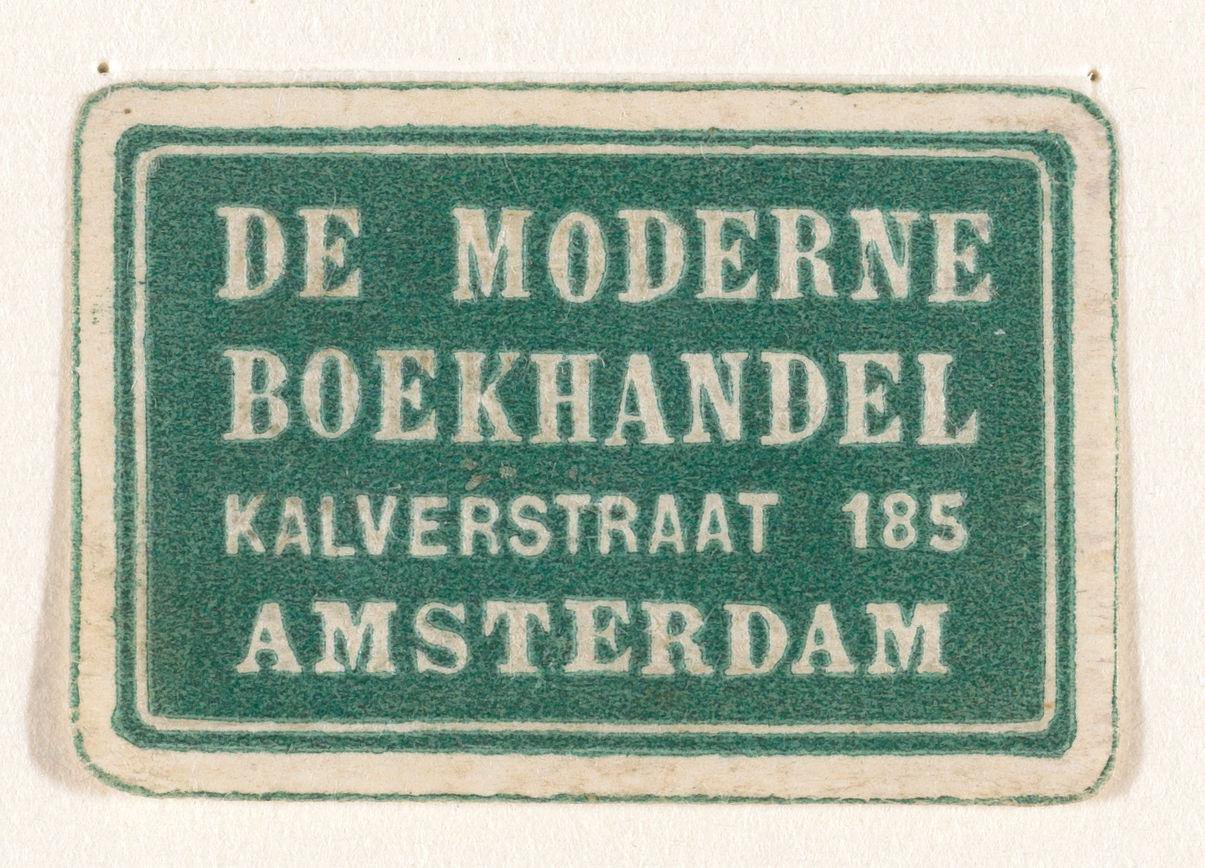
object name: boekhandelsetiket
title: Boekhandelsetiket van De Moderne Boekhandel te Amsterdam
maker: Anonymous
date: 1935-1956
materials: paper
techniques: lithograph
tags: amsterdam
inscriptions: collector's mark: Lugt 2228